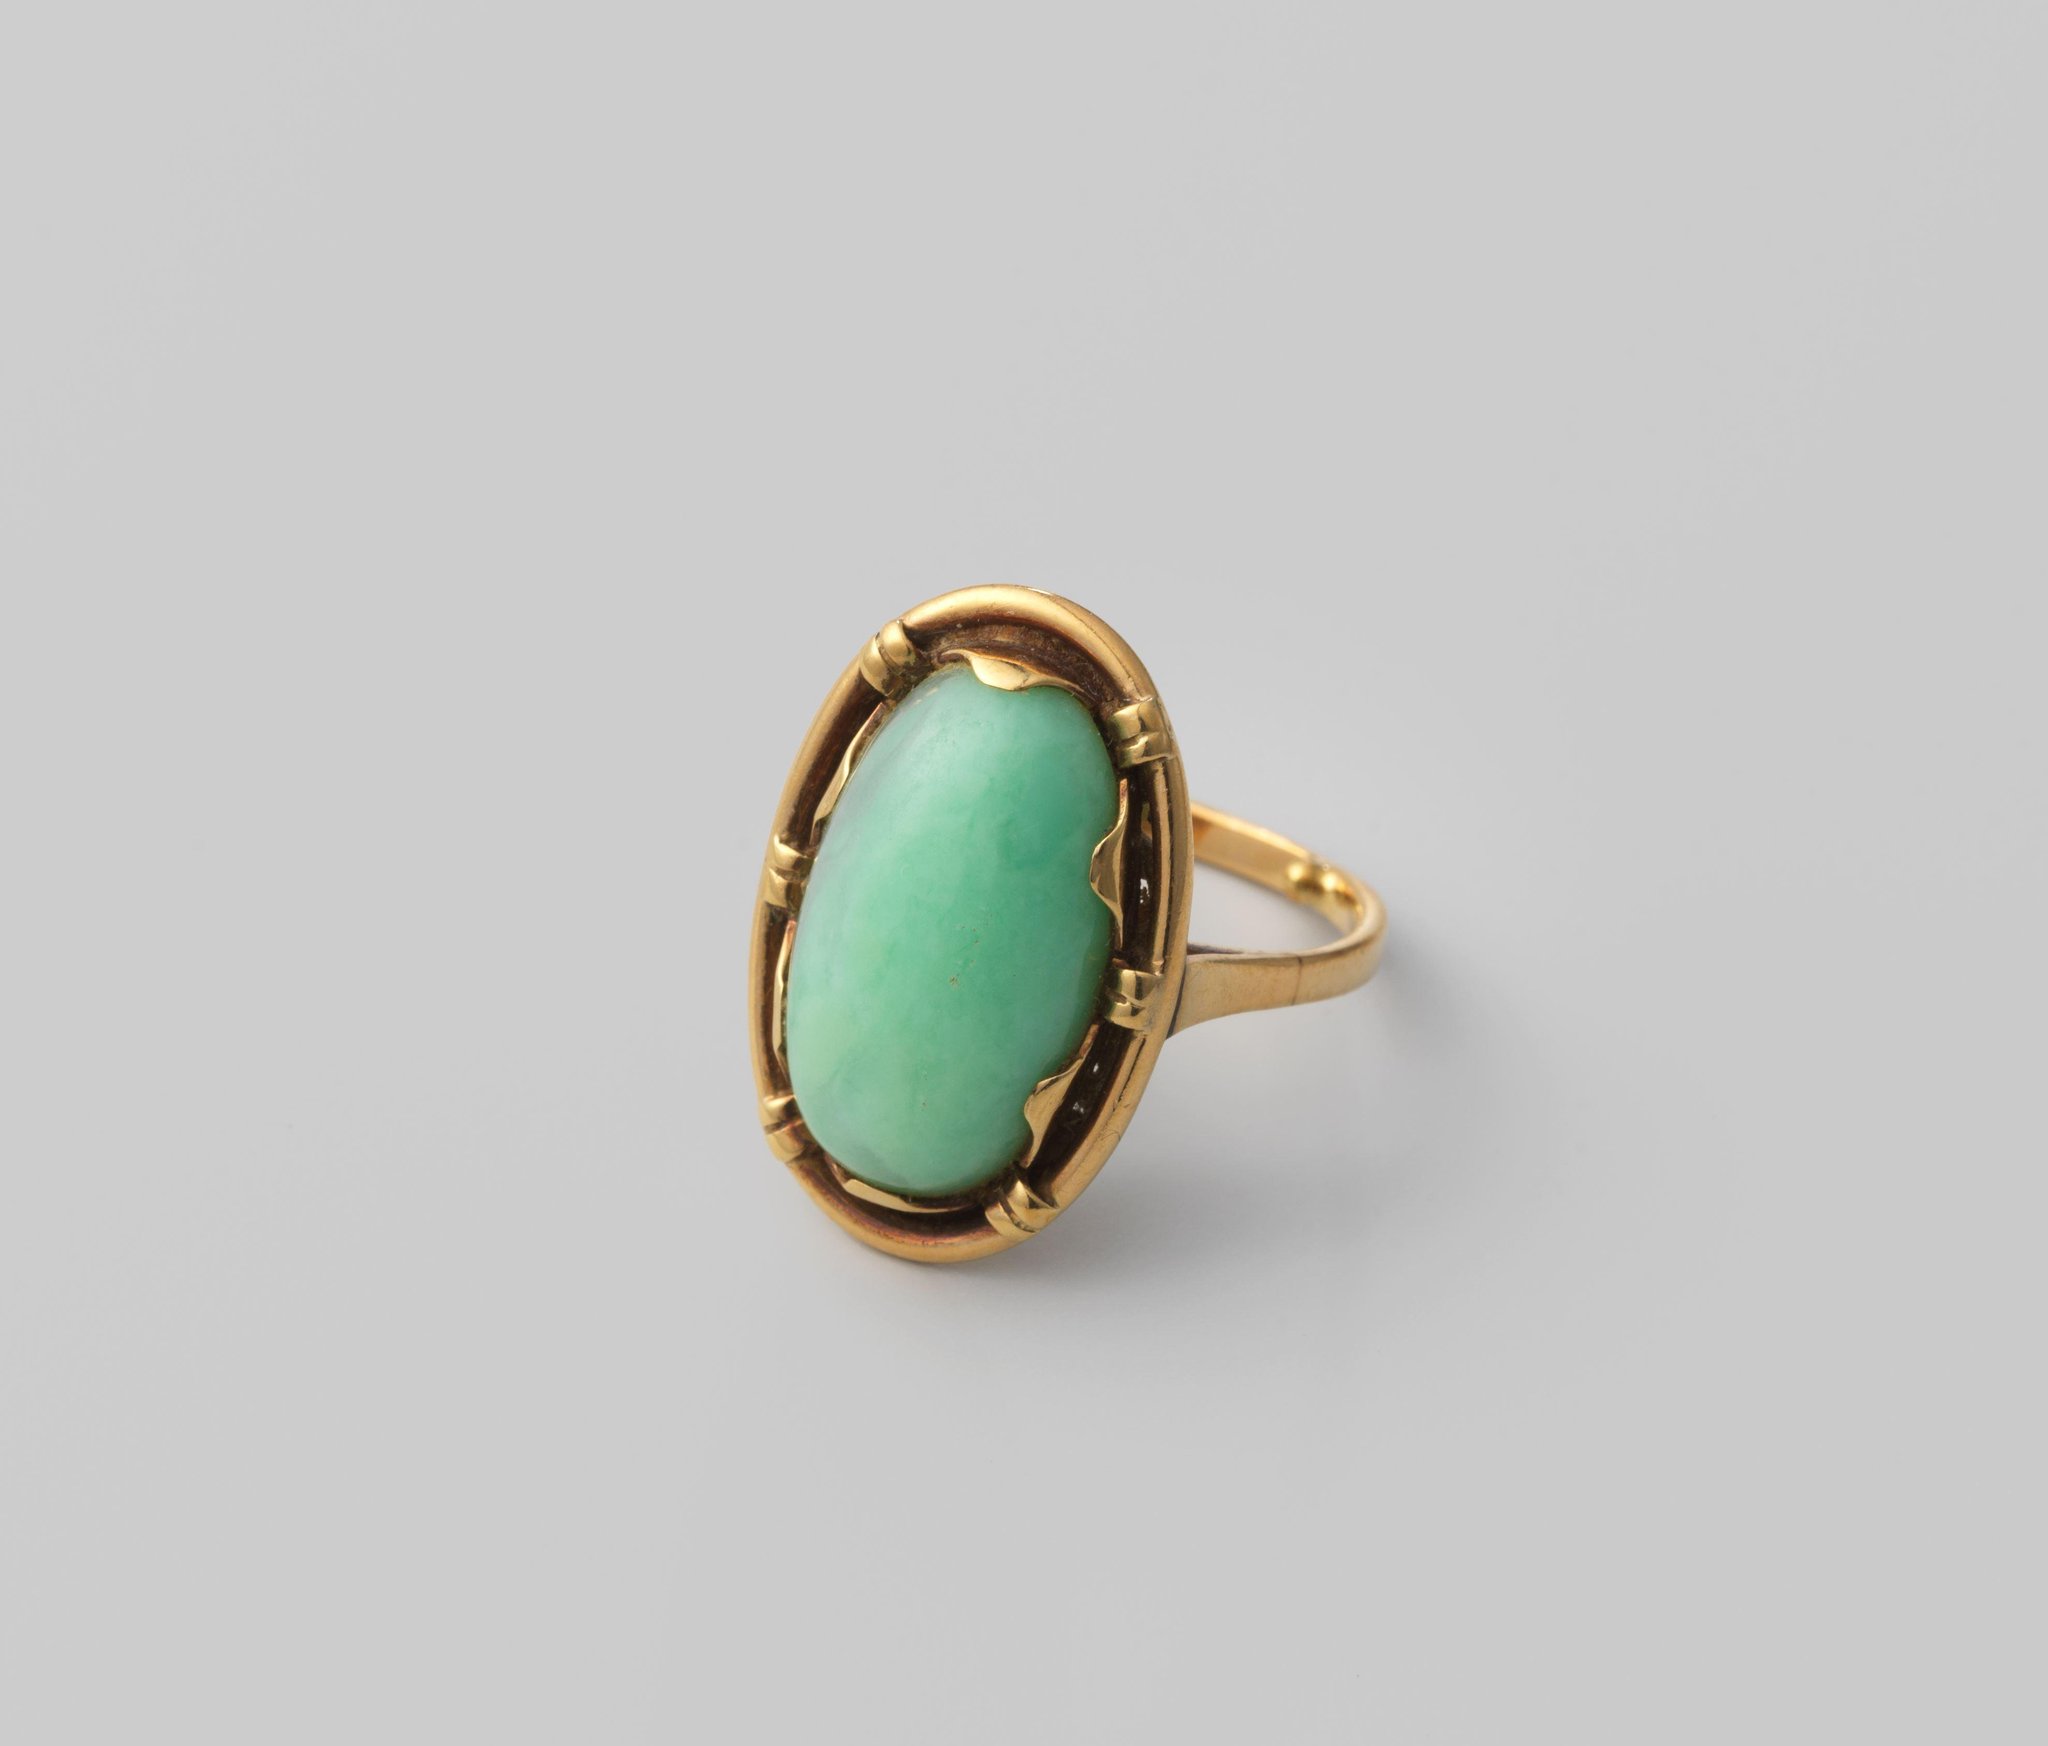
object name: ring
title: Ring van goud met amazoniet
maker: Anonymous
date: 1930-1940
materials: gold, quartz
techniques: grinding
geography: netherlands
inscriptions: alloy mark, maker's mark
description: Ring van goud met ovaal cabochon geslepen amazoniet.